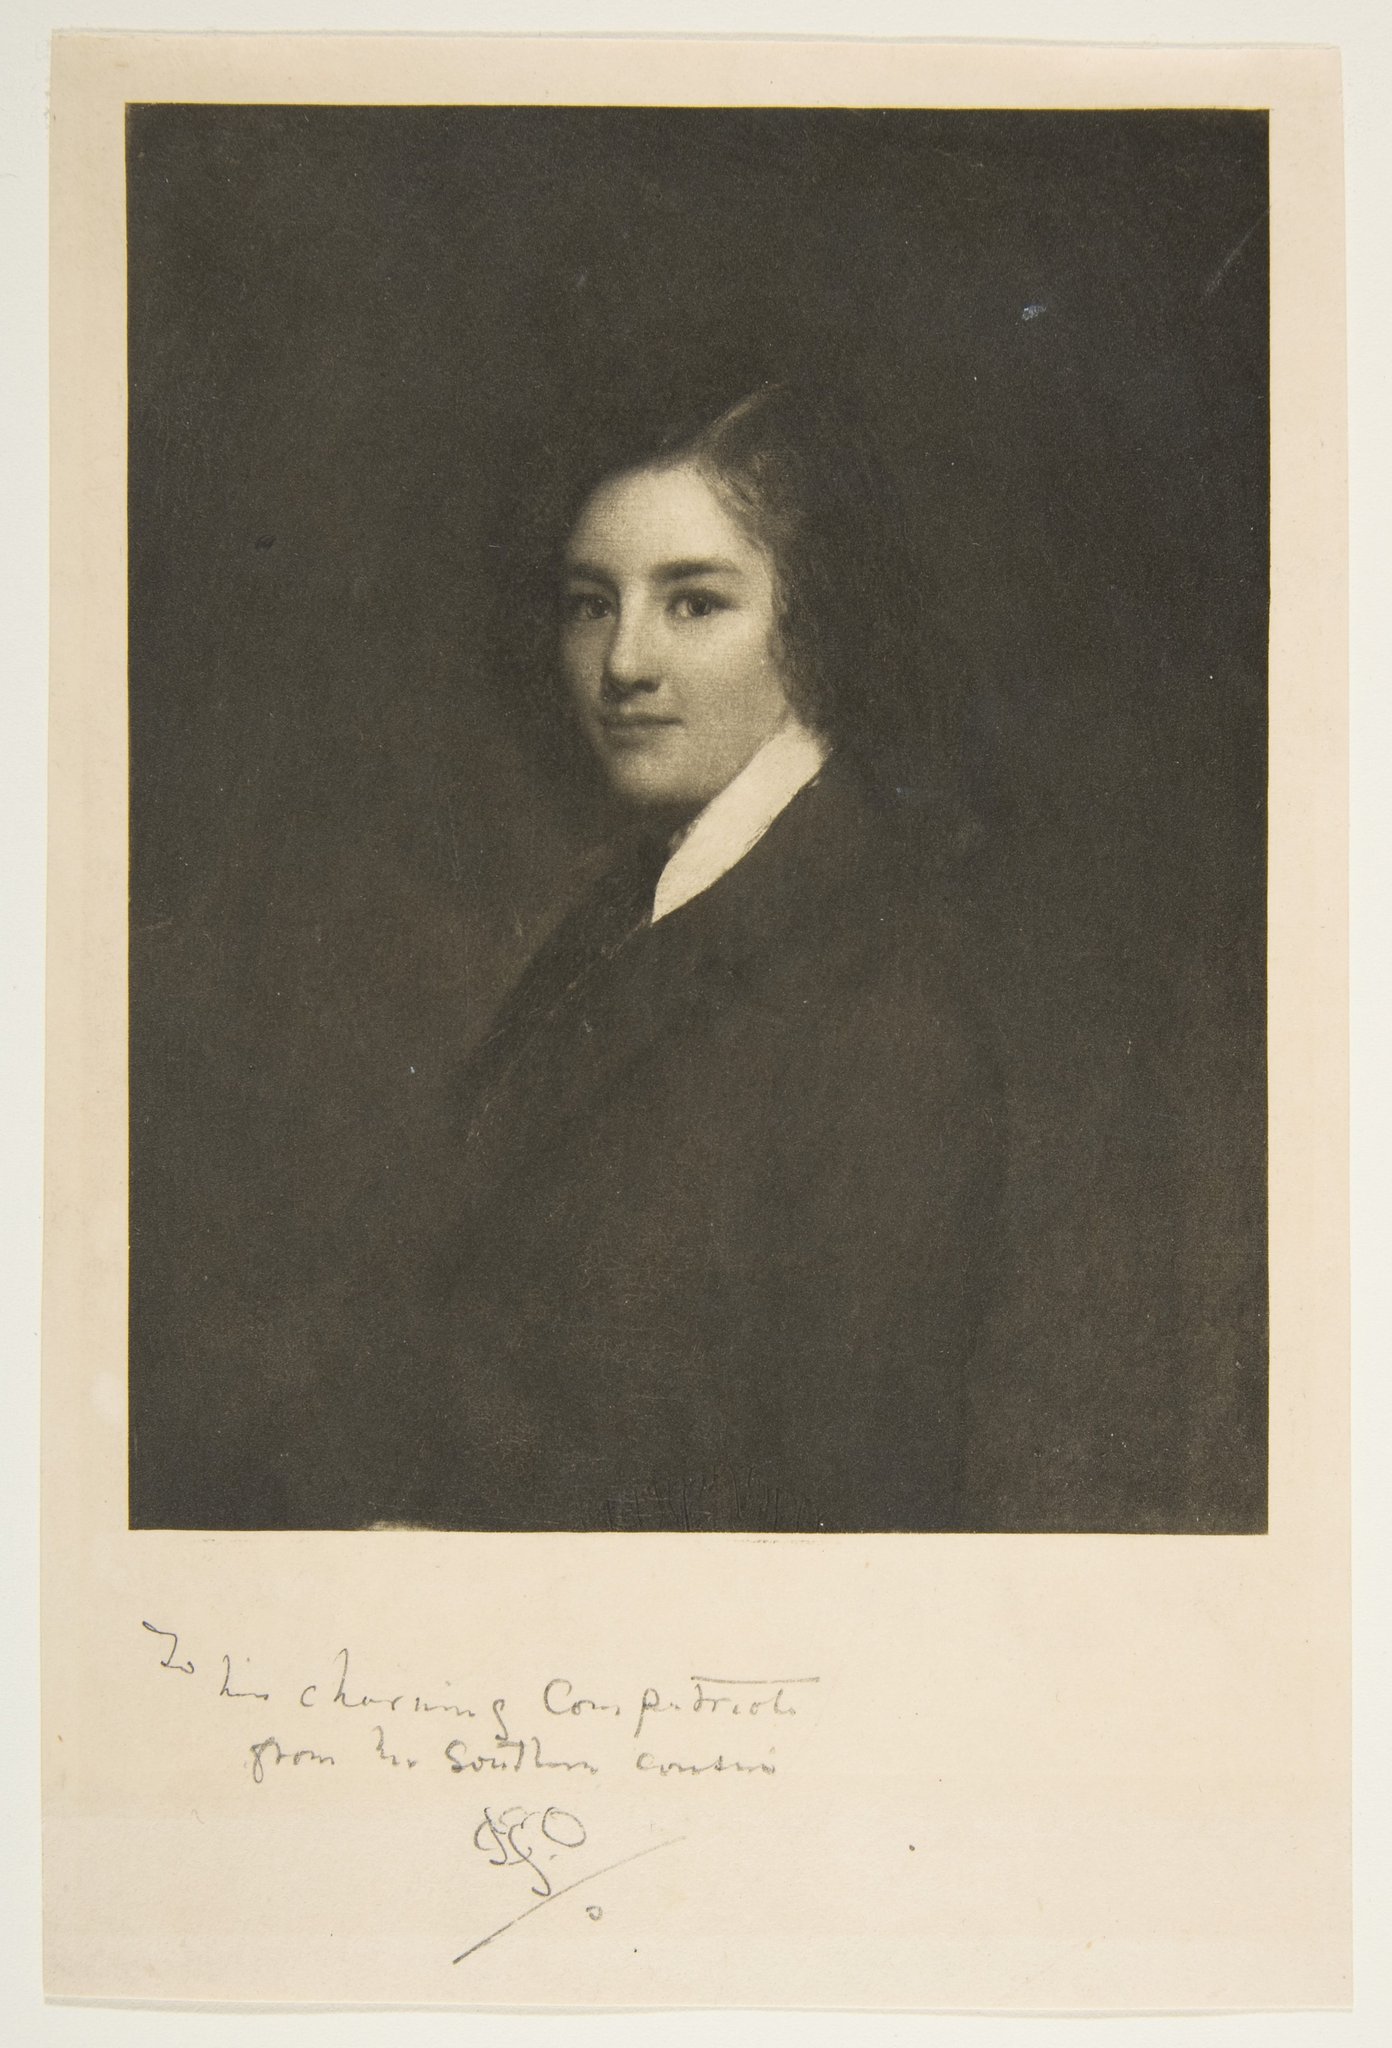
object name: print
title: James McNeill Whistler, Age 14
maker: sir william boxall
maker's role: artist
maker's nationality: british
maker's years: 1800-1879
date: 1848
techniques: photogravure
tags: boys,portraits